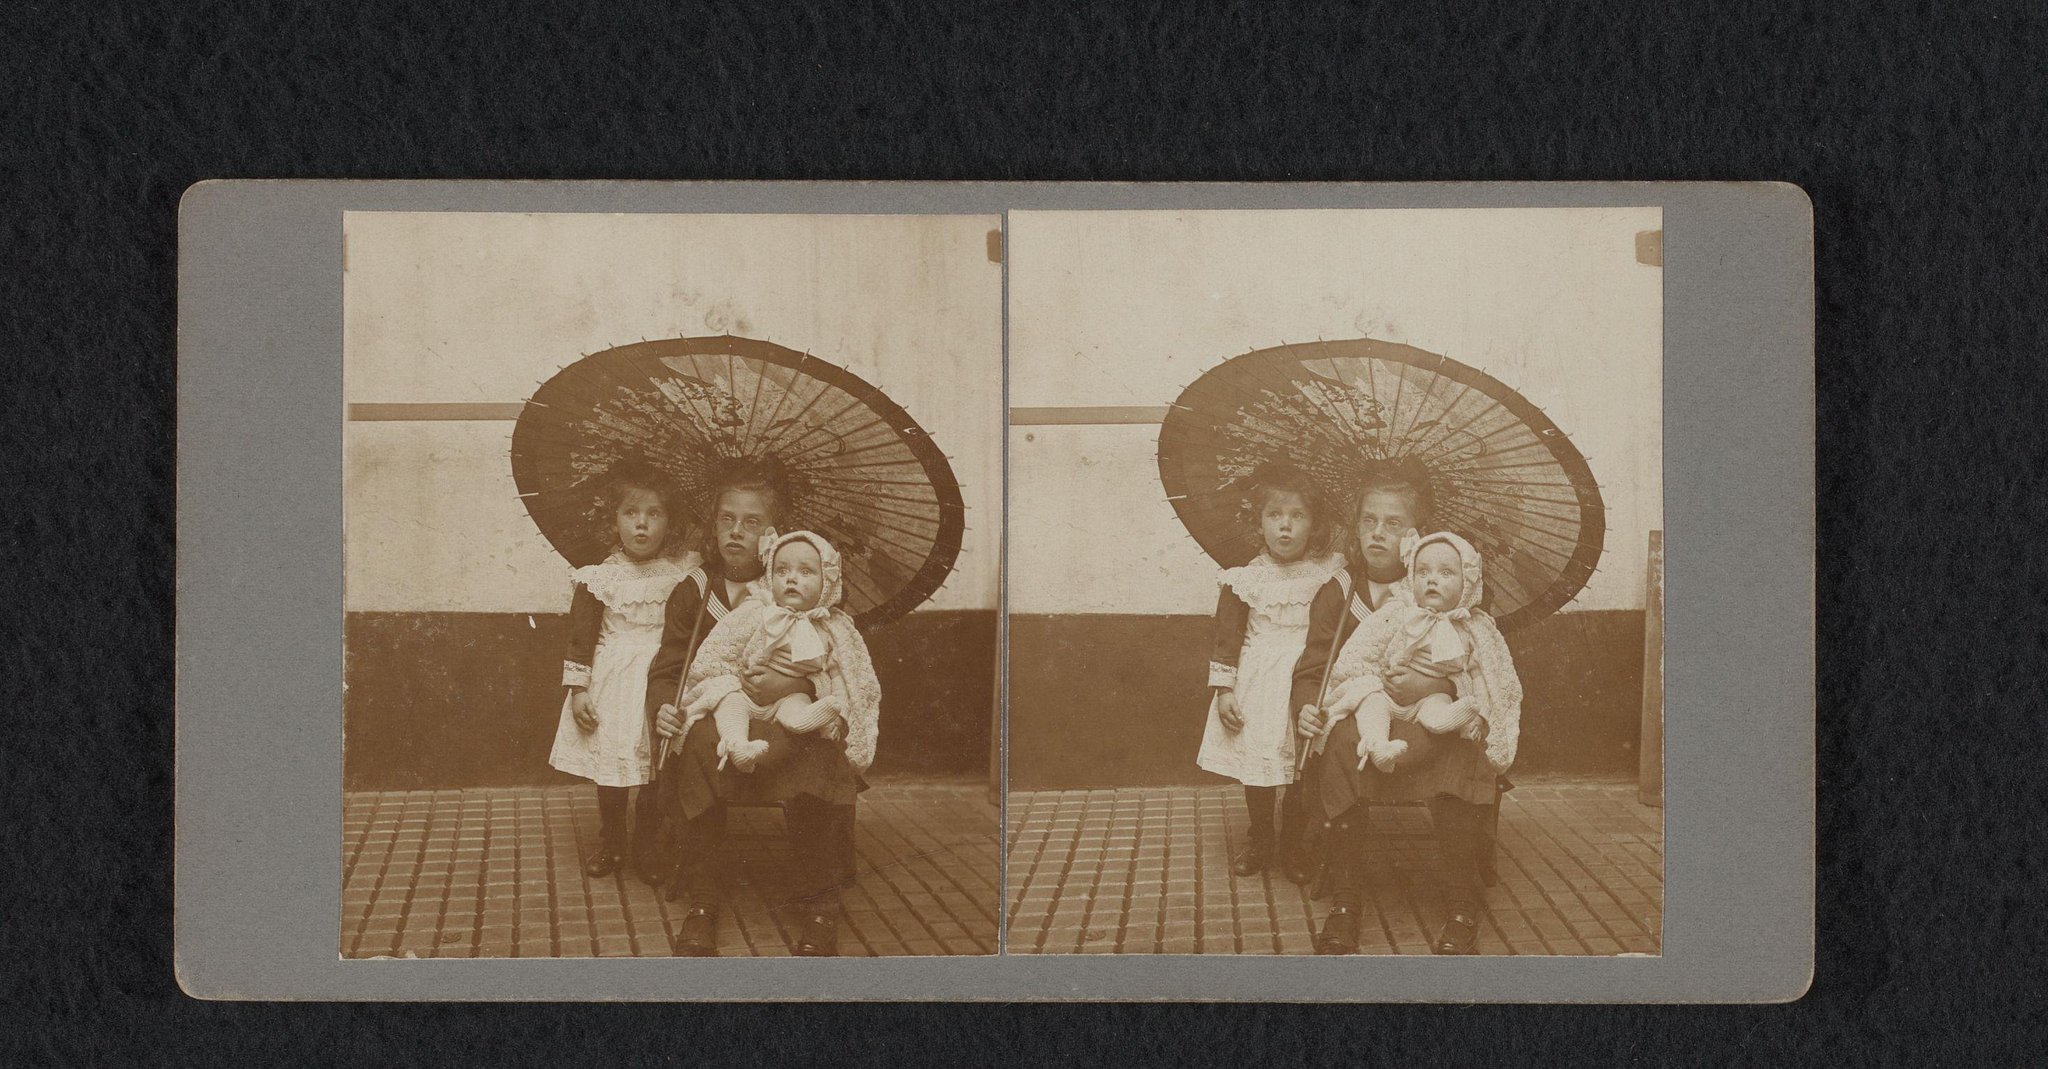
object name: stereograph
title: Portret van Jane, Rie en Jan Suyver onder een parasol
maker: machiel gerrit george suyver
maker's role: fotograaf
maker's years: 1872-1933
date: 1916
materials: paper, cardboard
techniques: gelatin silver print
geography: netherlands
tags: amsterdam, rotterdam, historical persons, brothers or sisters (second degree family relationships), parasol, sunshade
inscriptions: inscription: ‘Jane, Rie en Jan Suyver’